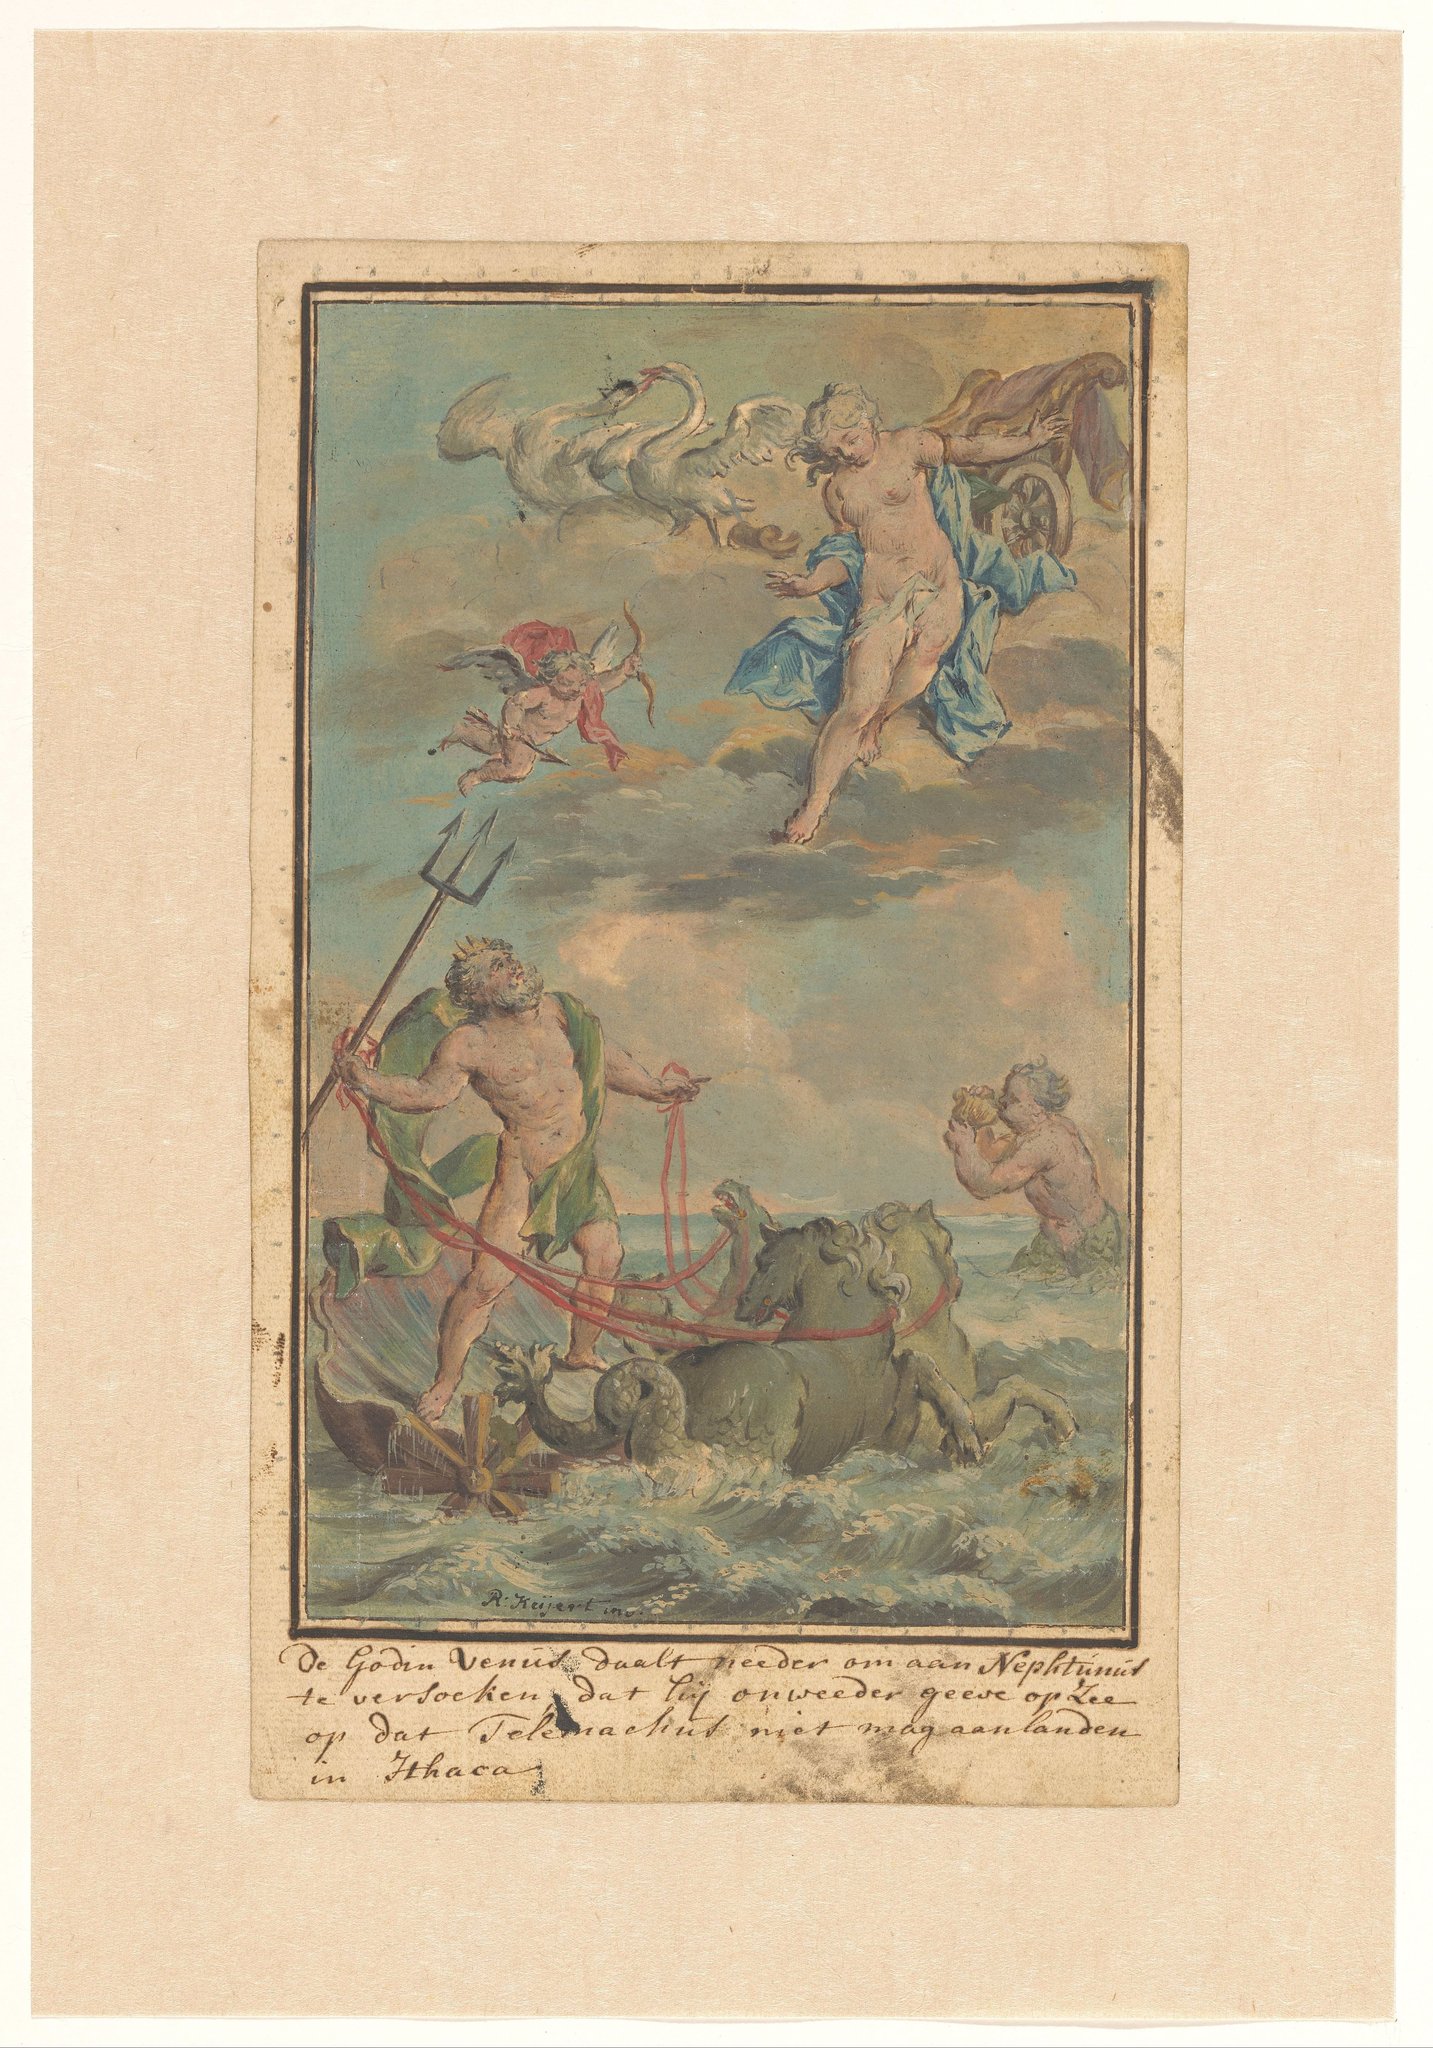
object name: drawing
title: Venus verzoekt Neptunus te verhinderen dat Telemachus zal landen op Ithaca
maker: rienk keyert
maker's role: draughtsman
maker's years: 1709-1775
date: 1719-1775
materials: ink, paper, watercolor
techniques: brush, pen, drawing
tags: (story of) telemachus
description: Venus verzoekt Neptunus te verhinderen dat Telemachus zal landen op Ithaca. Onderaan in de marge beschrijving van de voorstelling. Ontwerp voor een behangschildering.